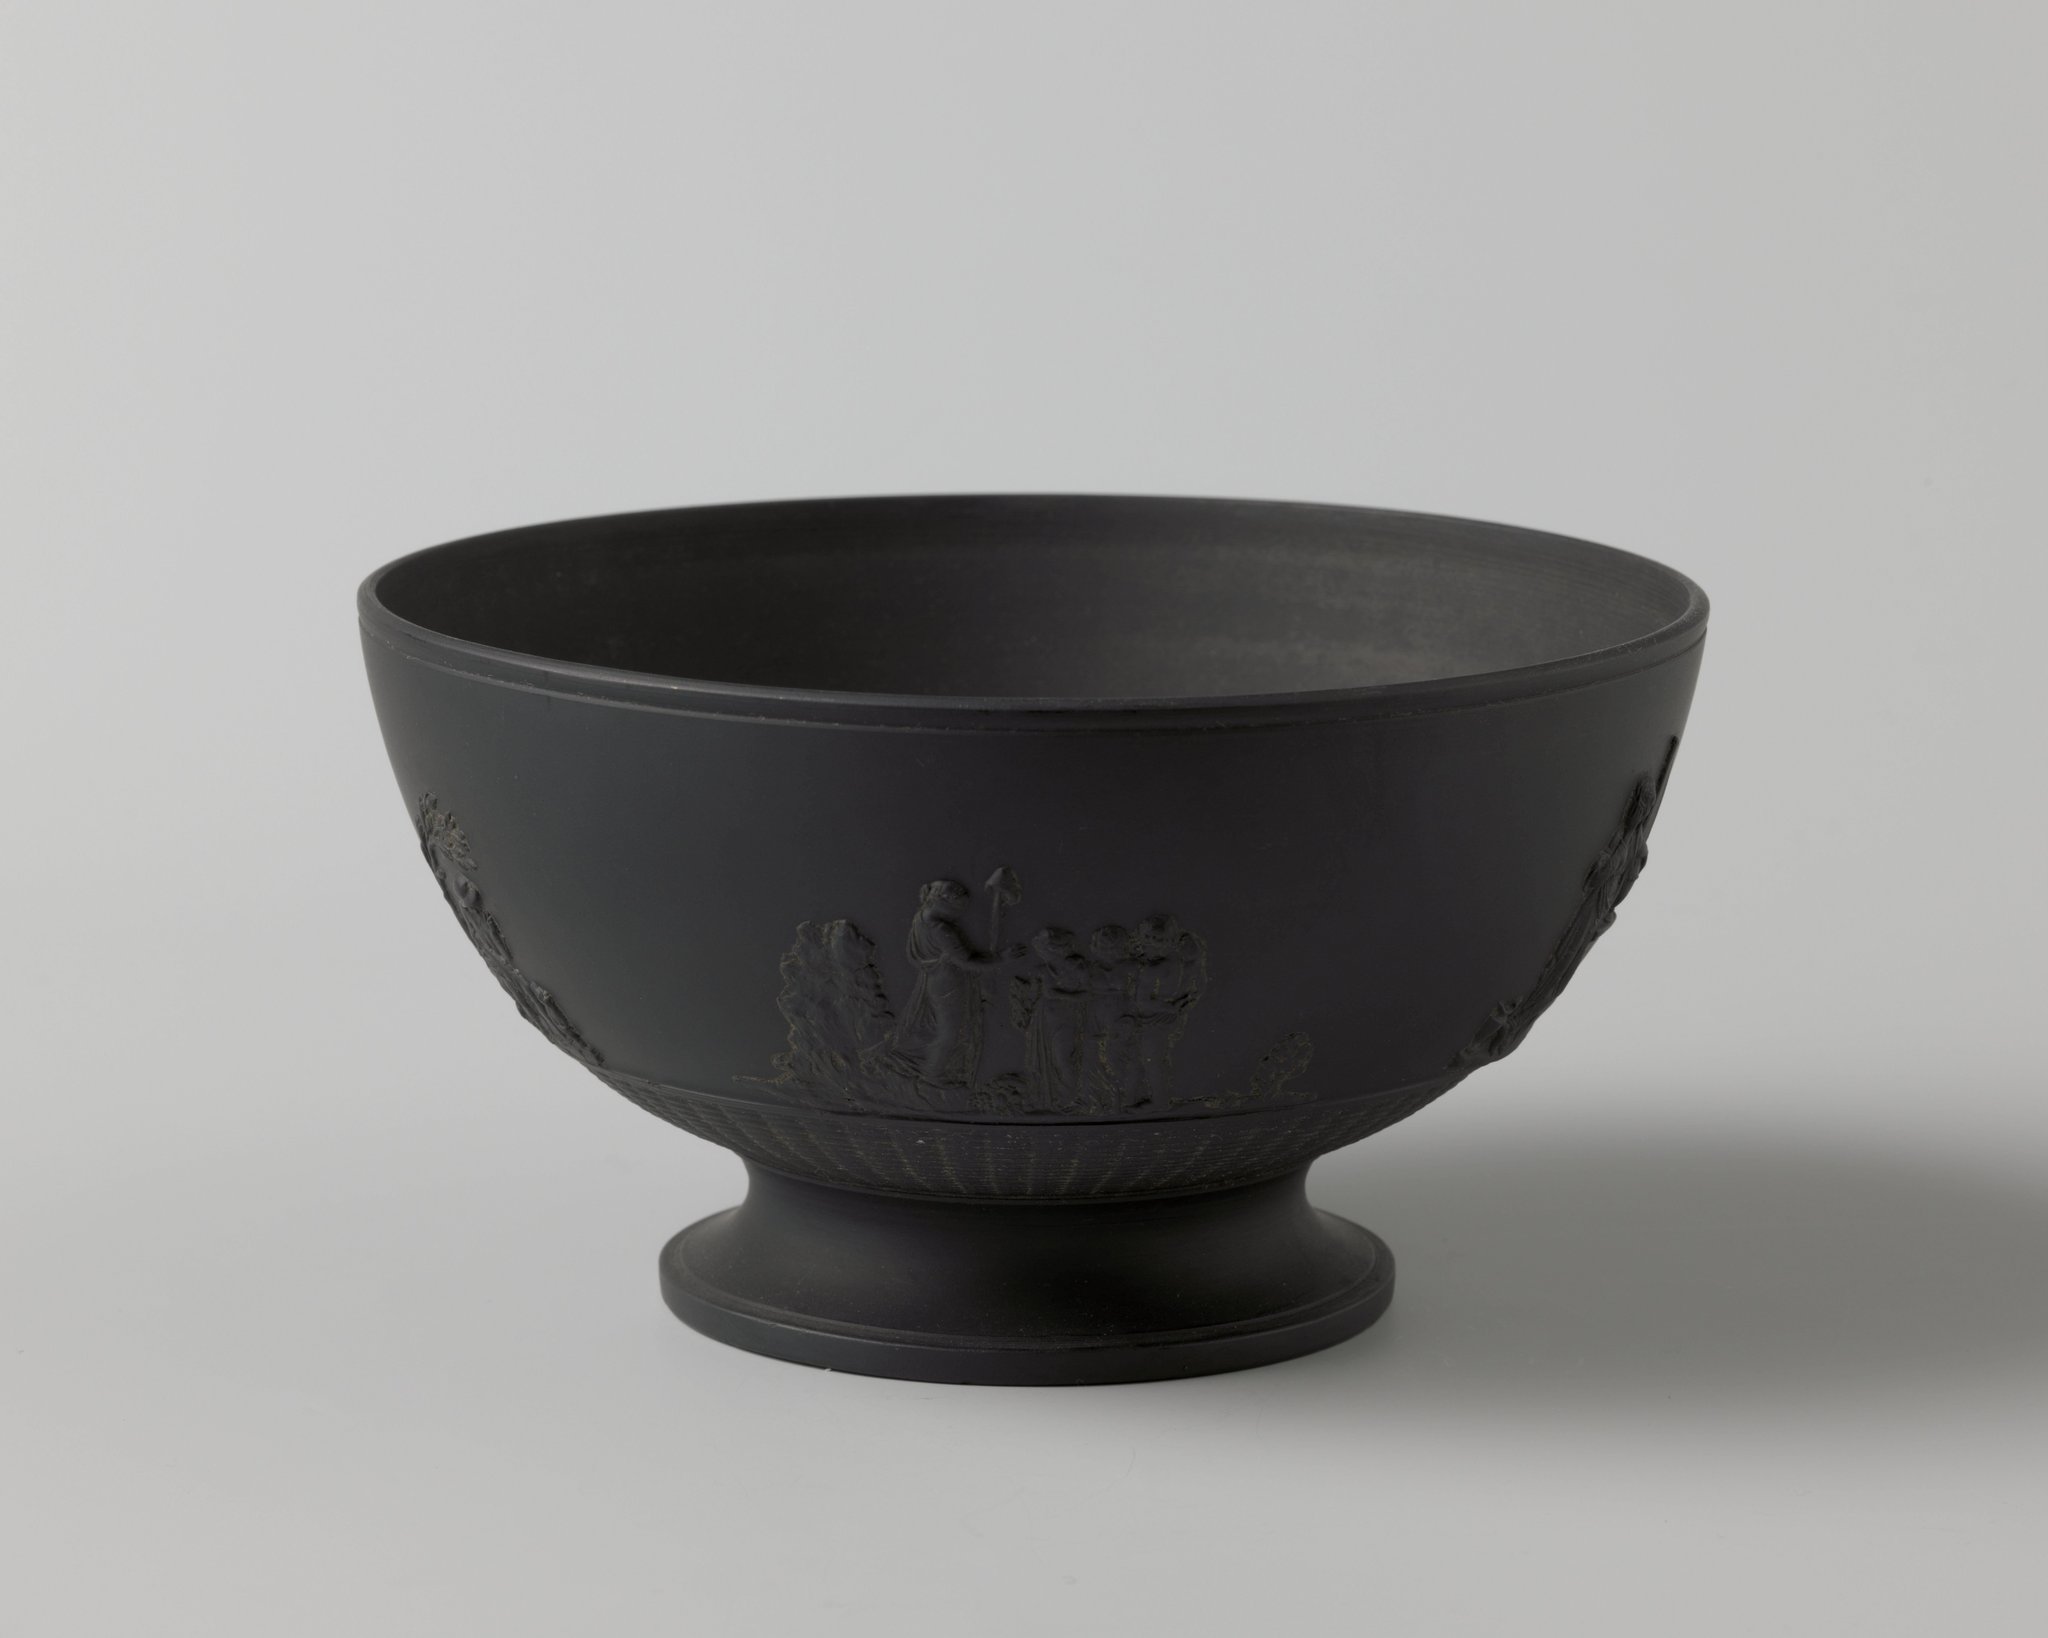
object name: bowl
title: Spoelkom van aardewerk, E.J. Birch Black Basalt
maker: edmund john birch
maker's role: aardewerkfabriek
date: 1785-1800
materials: earthenware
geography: hanley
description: Halfbolvormige spoelkom van aardewerk, Black Basalt. De kom staat op een geprofileerde voet, heeft daarboven een rand van geïmiteerd vlechtwerk en daarboven een fries met allegorische voorstellingen in reliëf (herder en herderin). De kom is gemerkt.